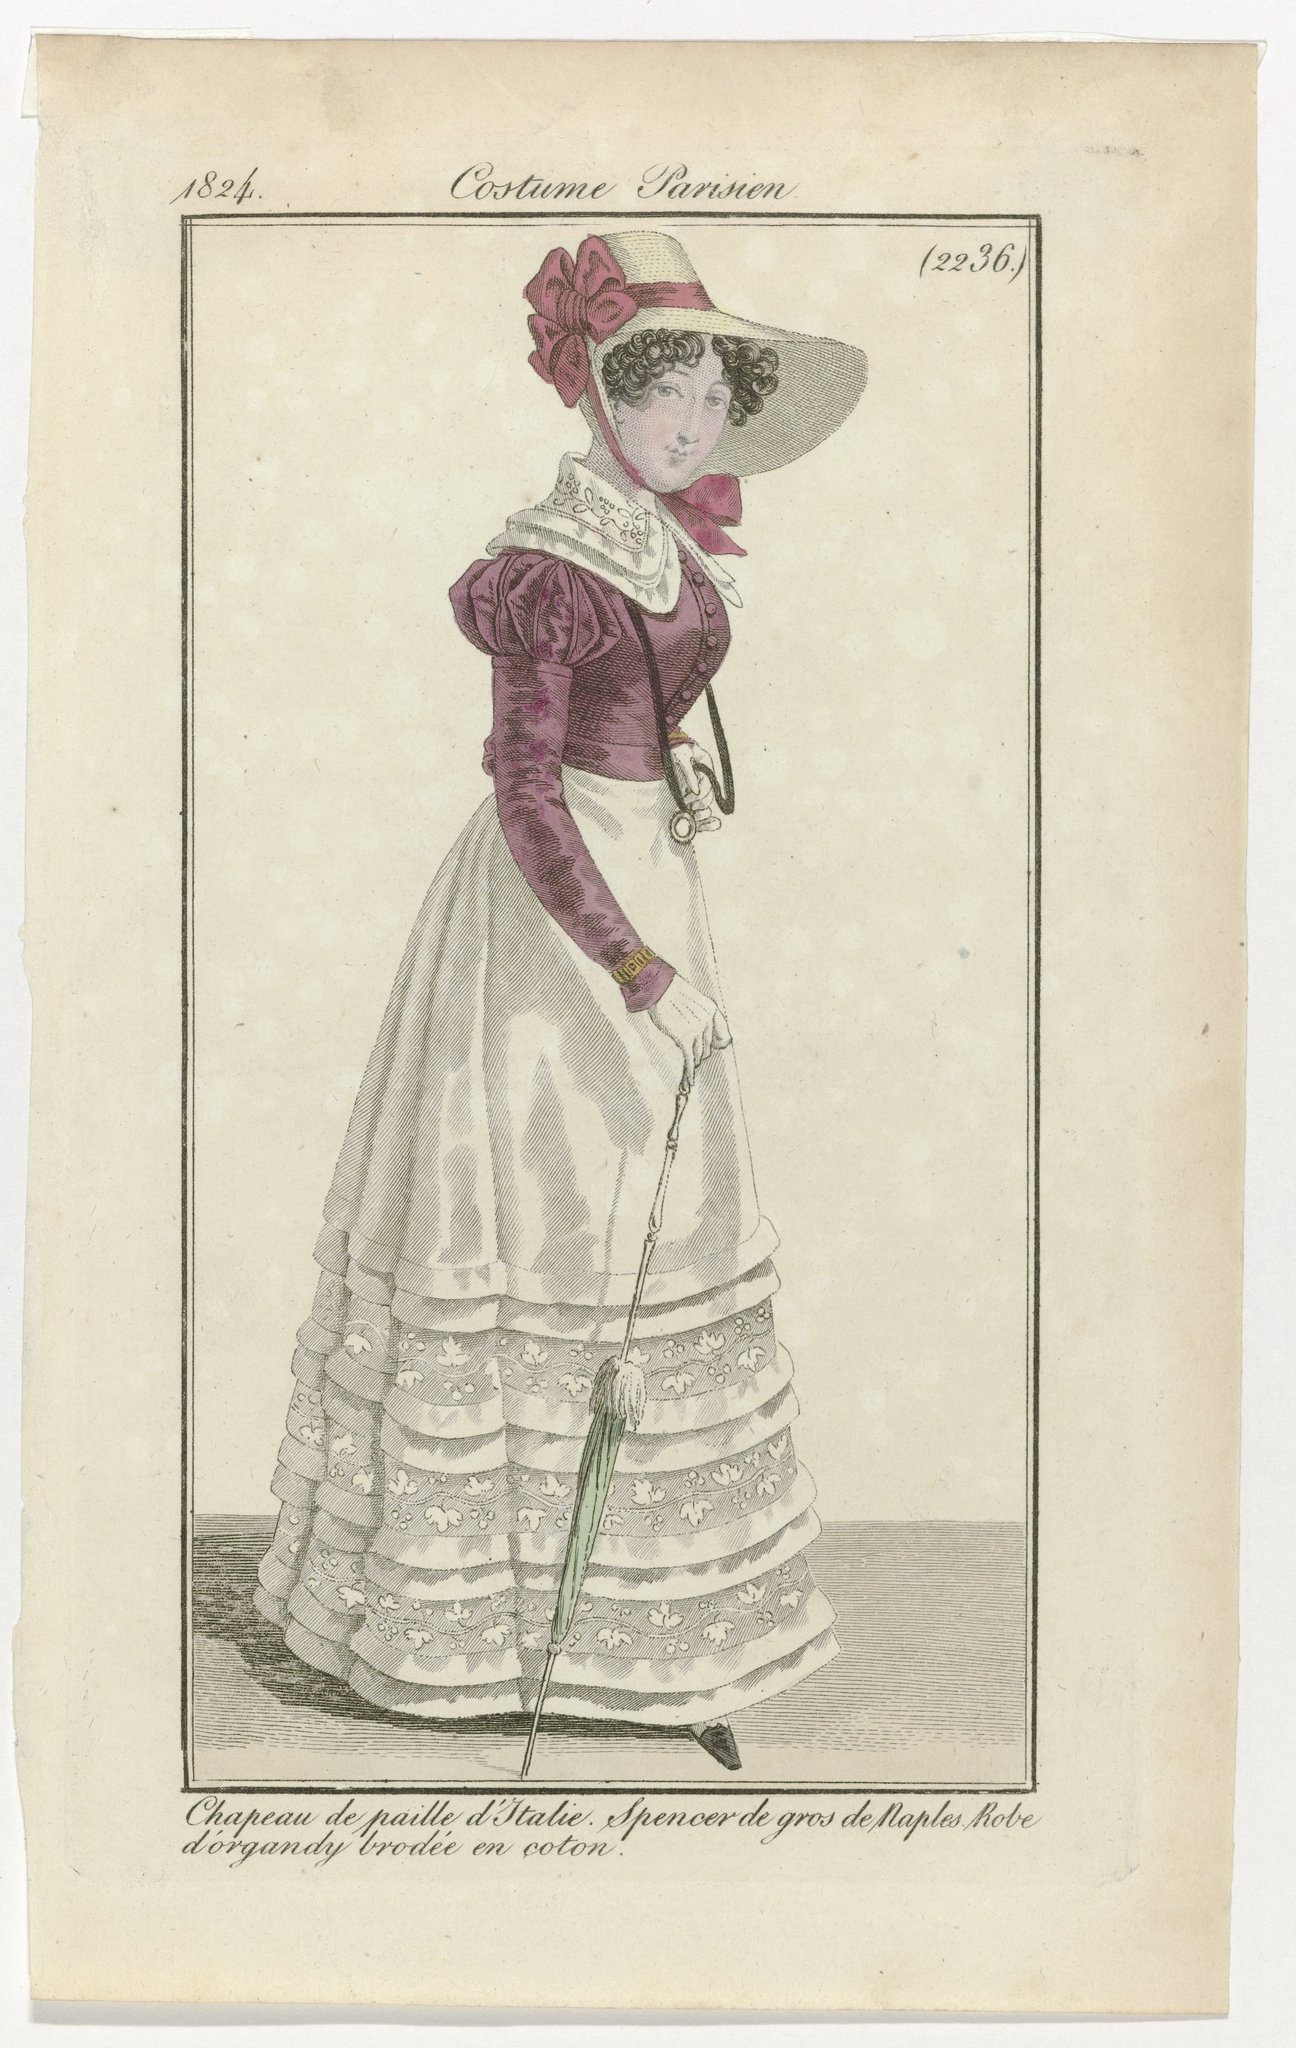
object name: fashion print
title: Journal des Dames et des Modes, Costume Parisien, 15 mai 1824, (2236): Chapeau de paille d'Itali (...)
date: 1824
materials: paper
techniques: engraving, hand coloring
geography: paris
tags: monocle, single lorgnette (+ female (human being) (not to be used where -aa- is prescribed)), clothing for the upper part of the body (spencer) (+ women's clothes), fashion plates, head-gear: hat (+ women's clothes), shoes, sandals (+ women's clothes), gloves, mittens, etc. (+ women's clothes), dress, gown (+ women's clothes), neck-gear ~ clothing (+ women's clothes), bracelet, wristlet (+ women's clothes), parasol, sunshade (+ women's clothes)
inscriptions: caption: ‘Chapeau de paille d'Italie. Spencer de gros de Naples. Robe d'organdy brodée en coton.’, title: ‘Costume Parisien.’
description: Staande vrouw in een spencer van 'gros de Naples' op een japon van organdie geborduurd met katoen. Op het hoofd een hoed van 'paille d'Italie'. Verdere accessoires: handschoenen, lorgnet met koord, armband om de rechterpols, parasol, schoen met vierkante neus. De prent maakt deel uit van het modetijdschrift Journal des Dames et des Modes, uitgegeven door Pierre de la Mésangère, Parijs, 1797-1839.